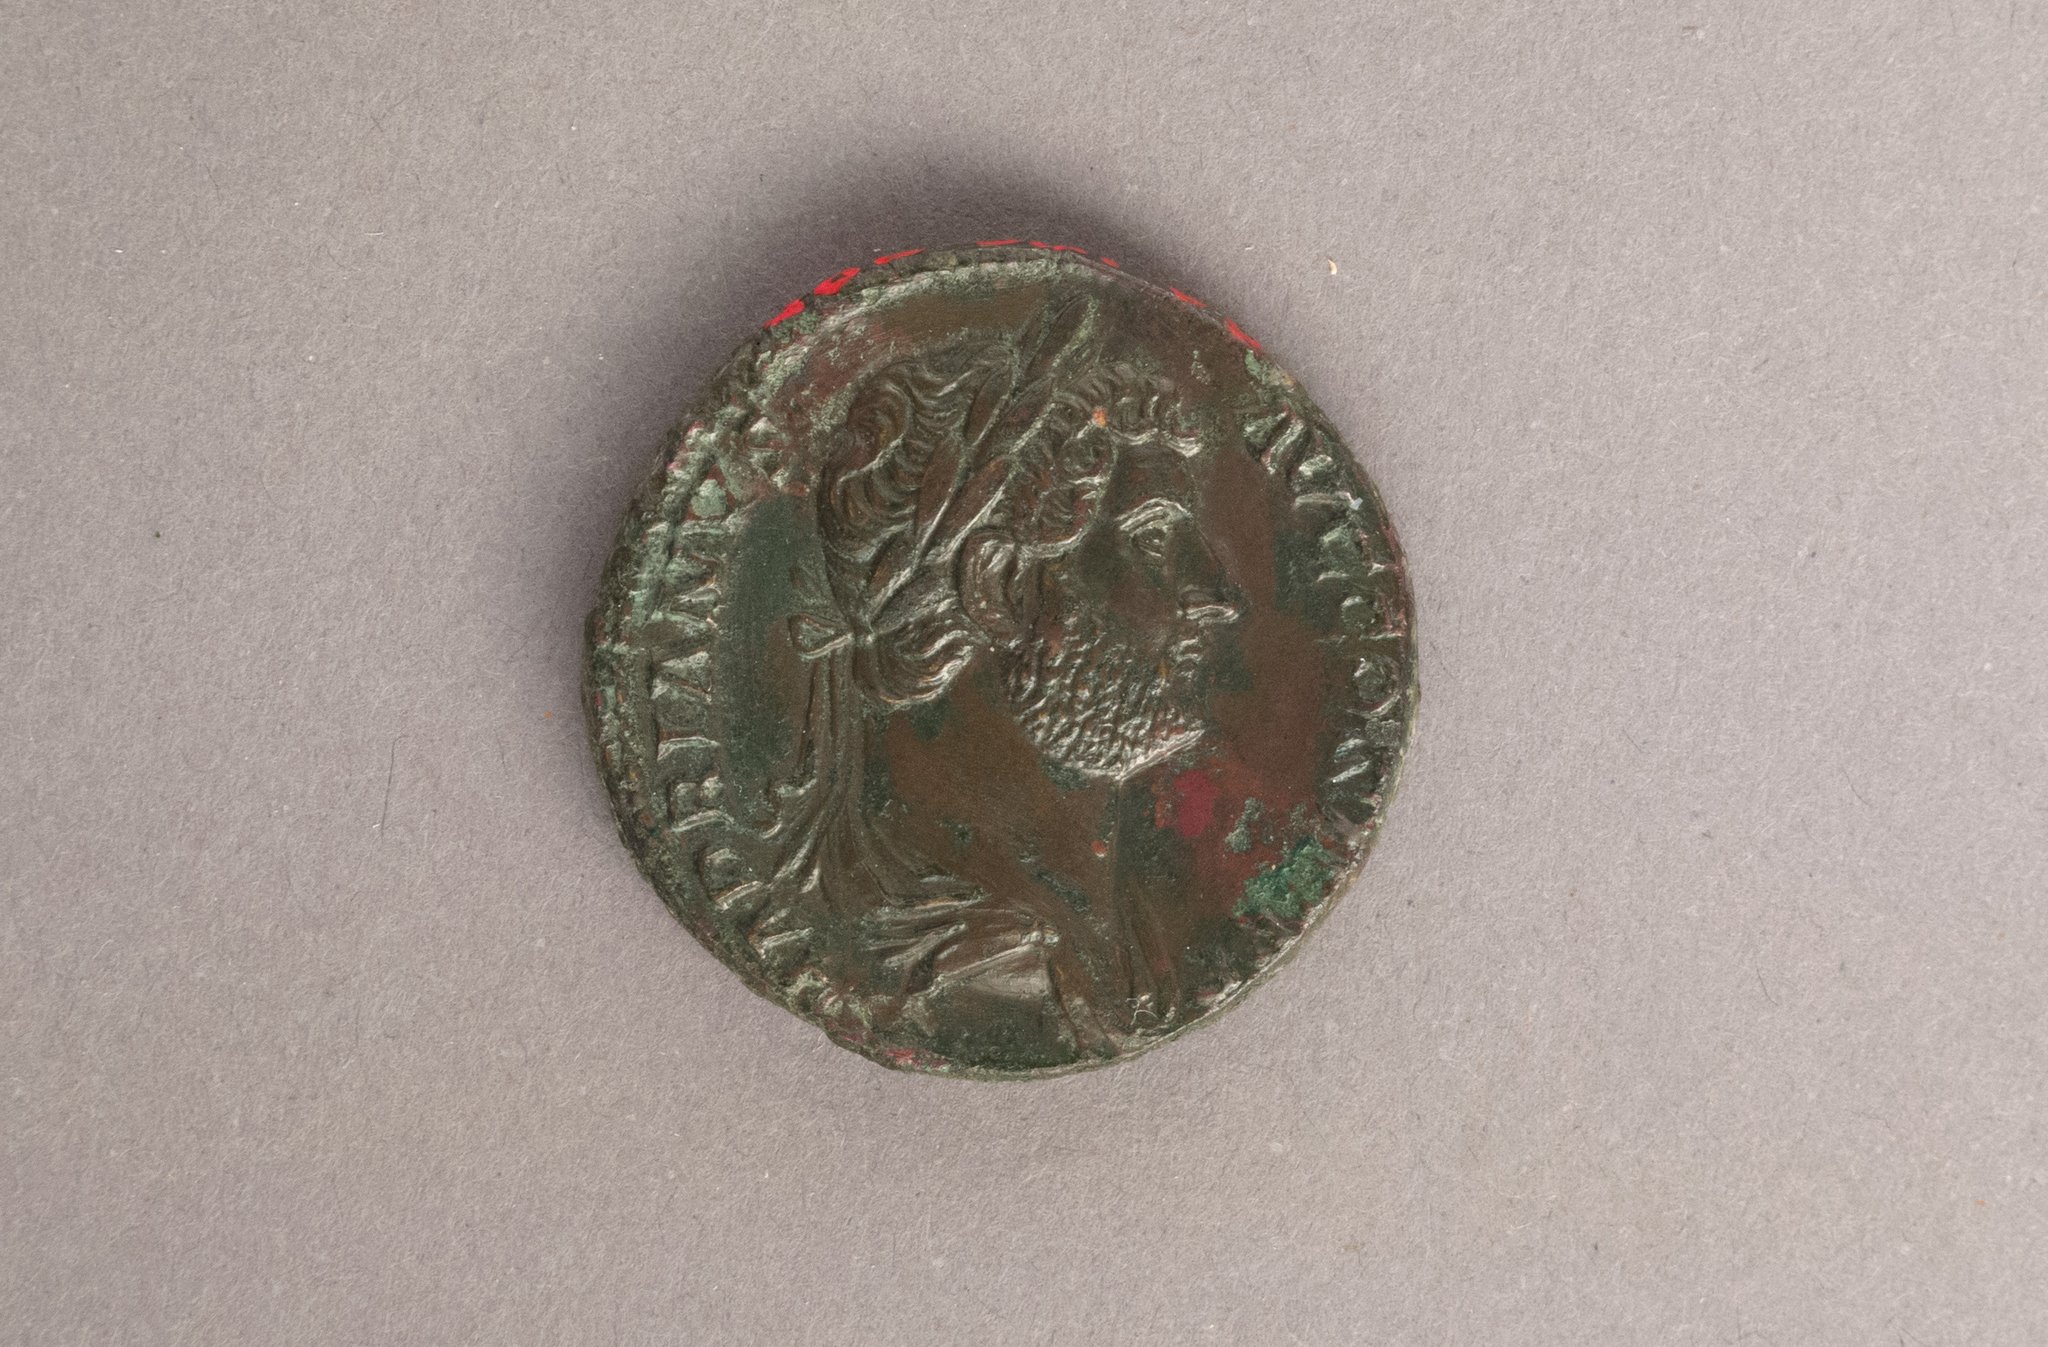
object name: sestertius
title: Bronze sestertius of Hadrian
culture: roman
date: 134-138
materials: bronze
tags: men,profiles